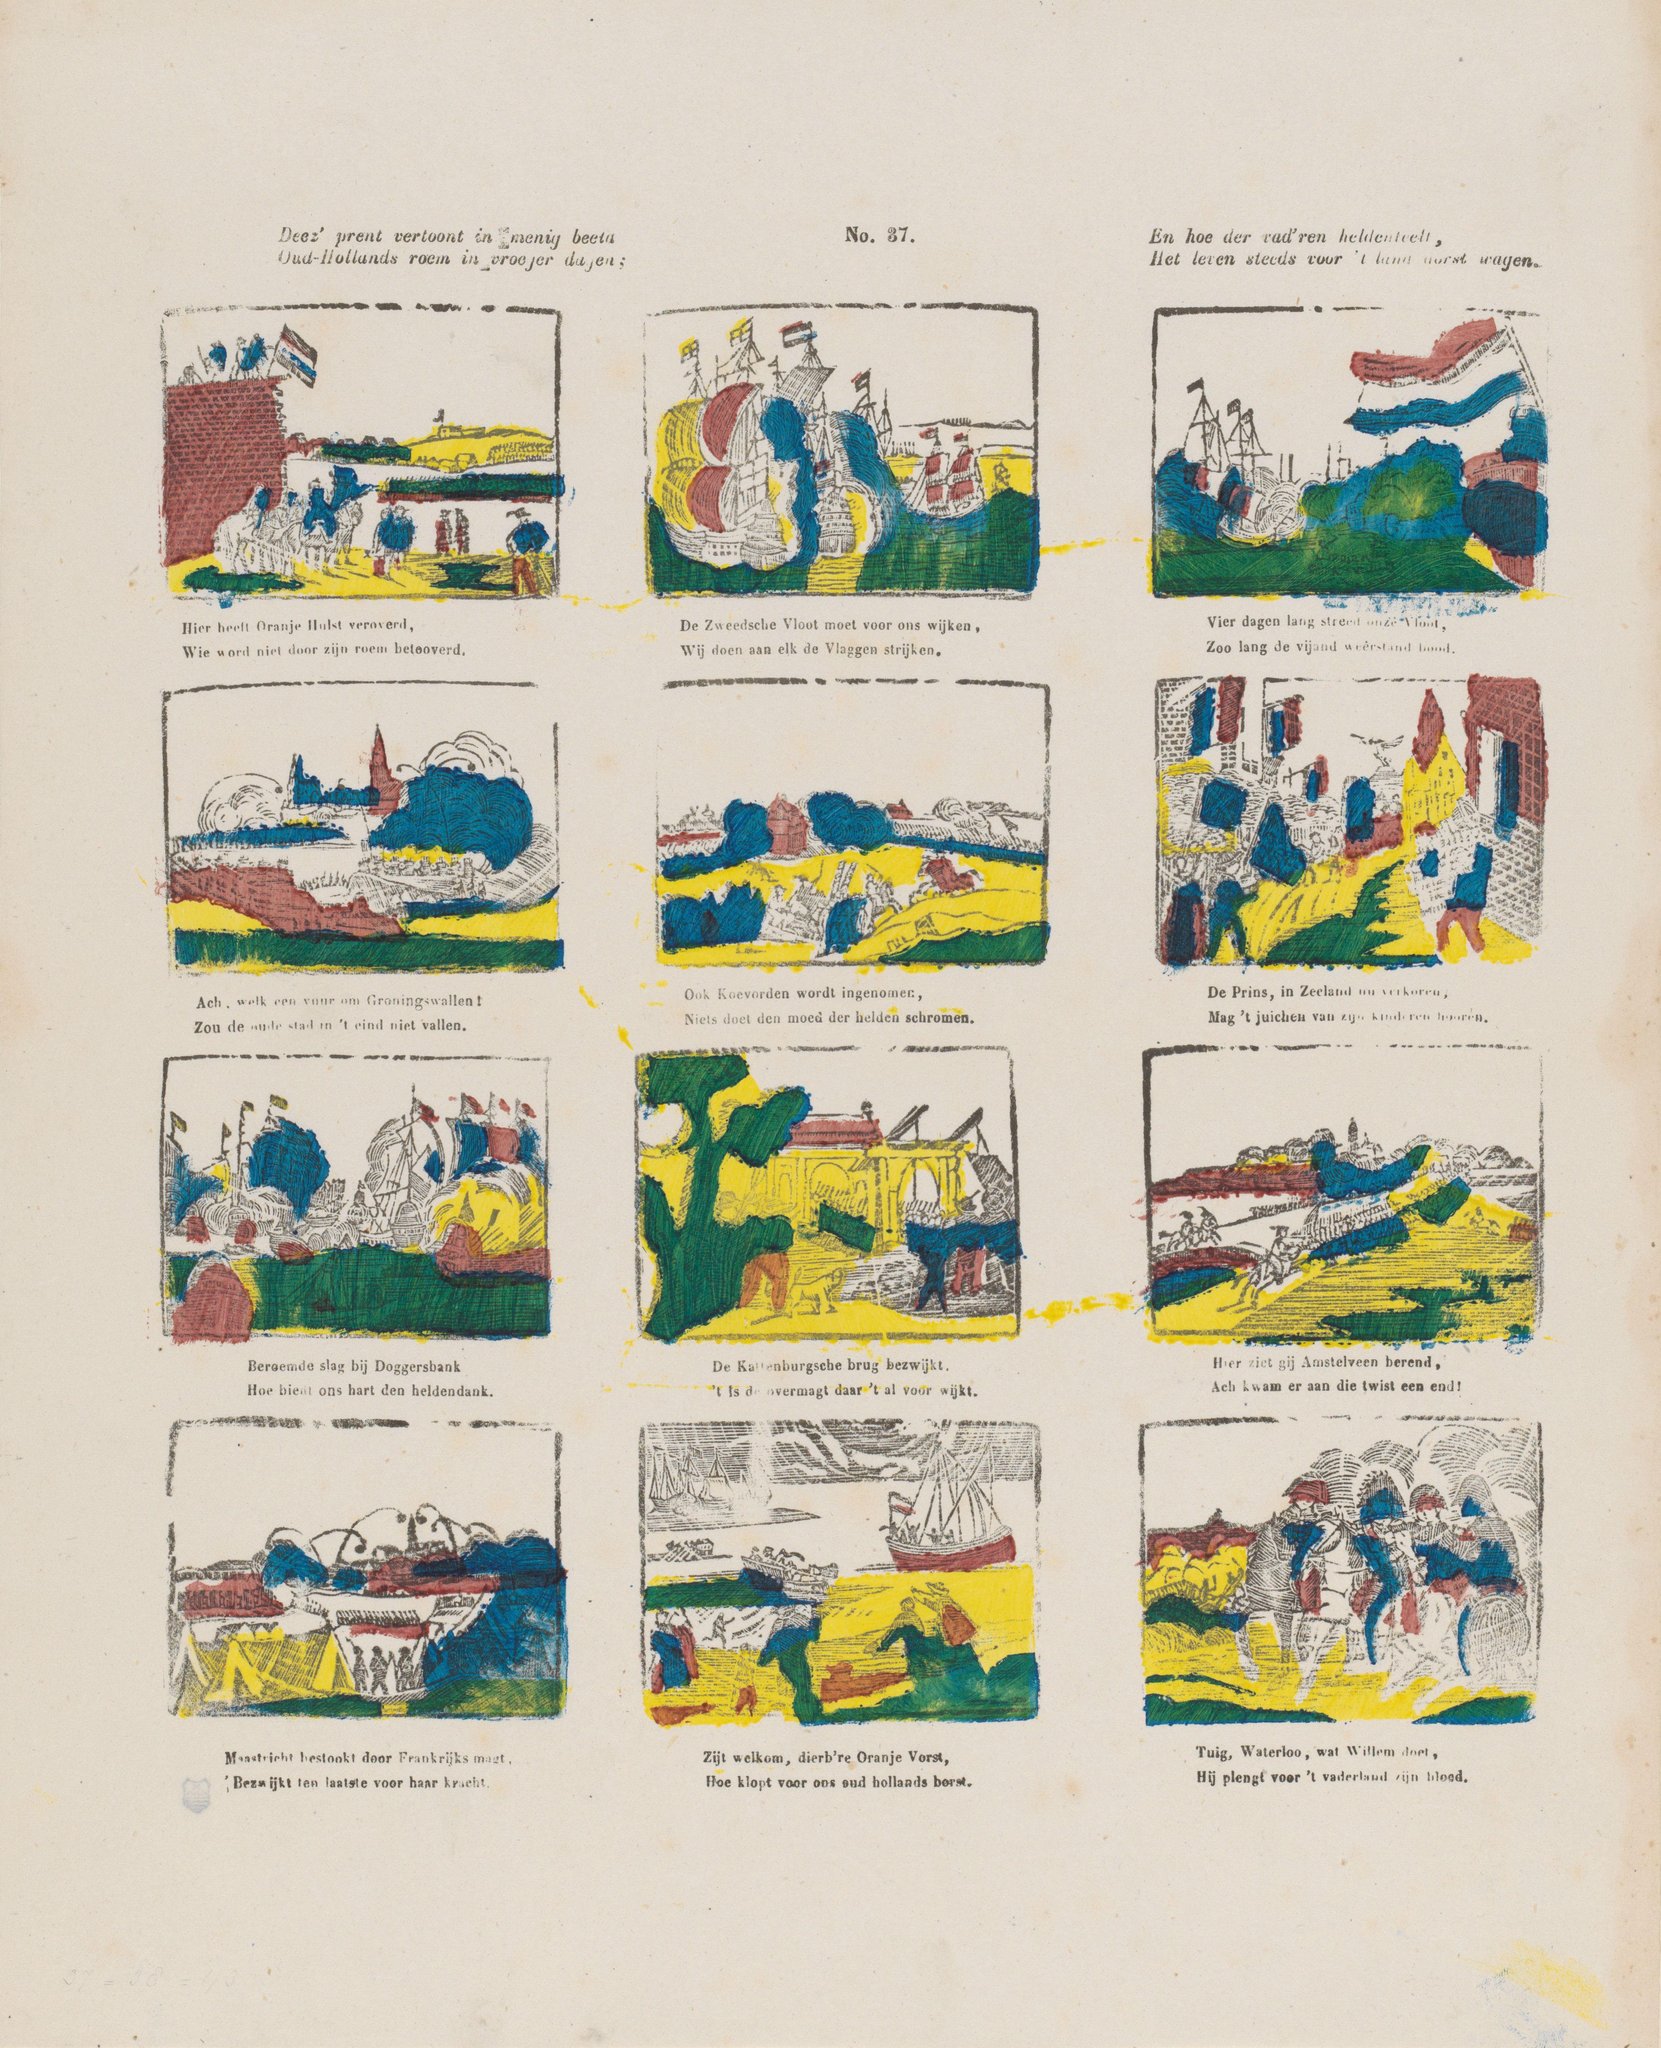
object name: print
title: Dee'z prent vertoont in menig beeld / Oud-Hollands roen in vroeger dagen; / En hoe der vad'ren heldenteelt, / Het leven steeds voor 't land dorst wagen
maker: Anonymous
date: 1848-1881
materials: paper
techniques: colour, letterpress printing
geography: den bosch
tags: history, battle, maastricht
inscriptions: collector's mark: Lugt 2760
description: Blad met 12 voorstellingen van veldslagen en zeeslagen uit de vaderlandse geschiedenis. Onder elke afbeelding een tweeregelig vers. Genummerd midden boven: No. 37.